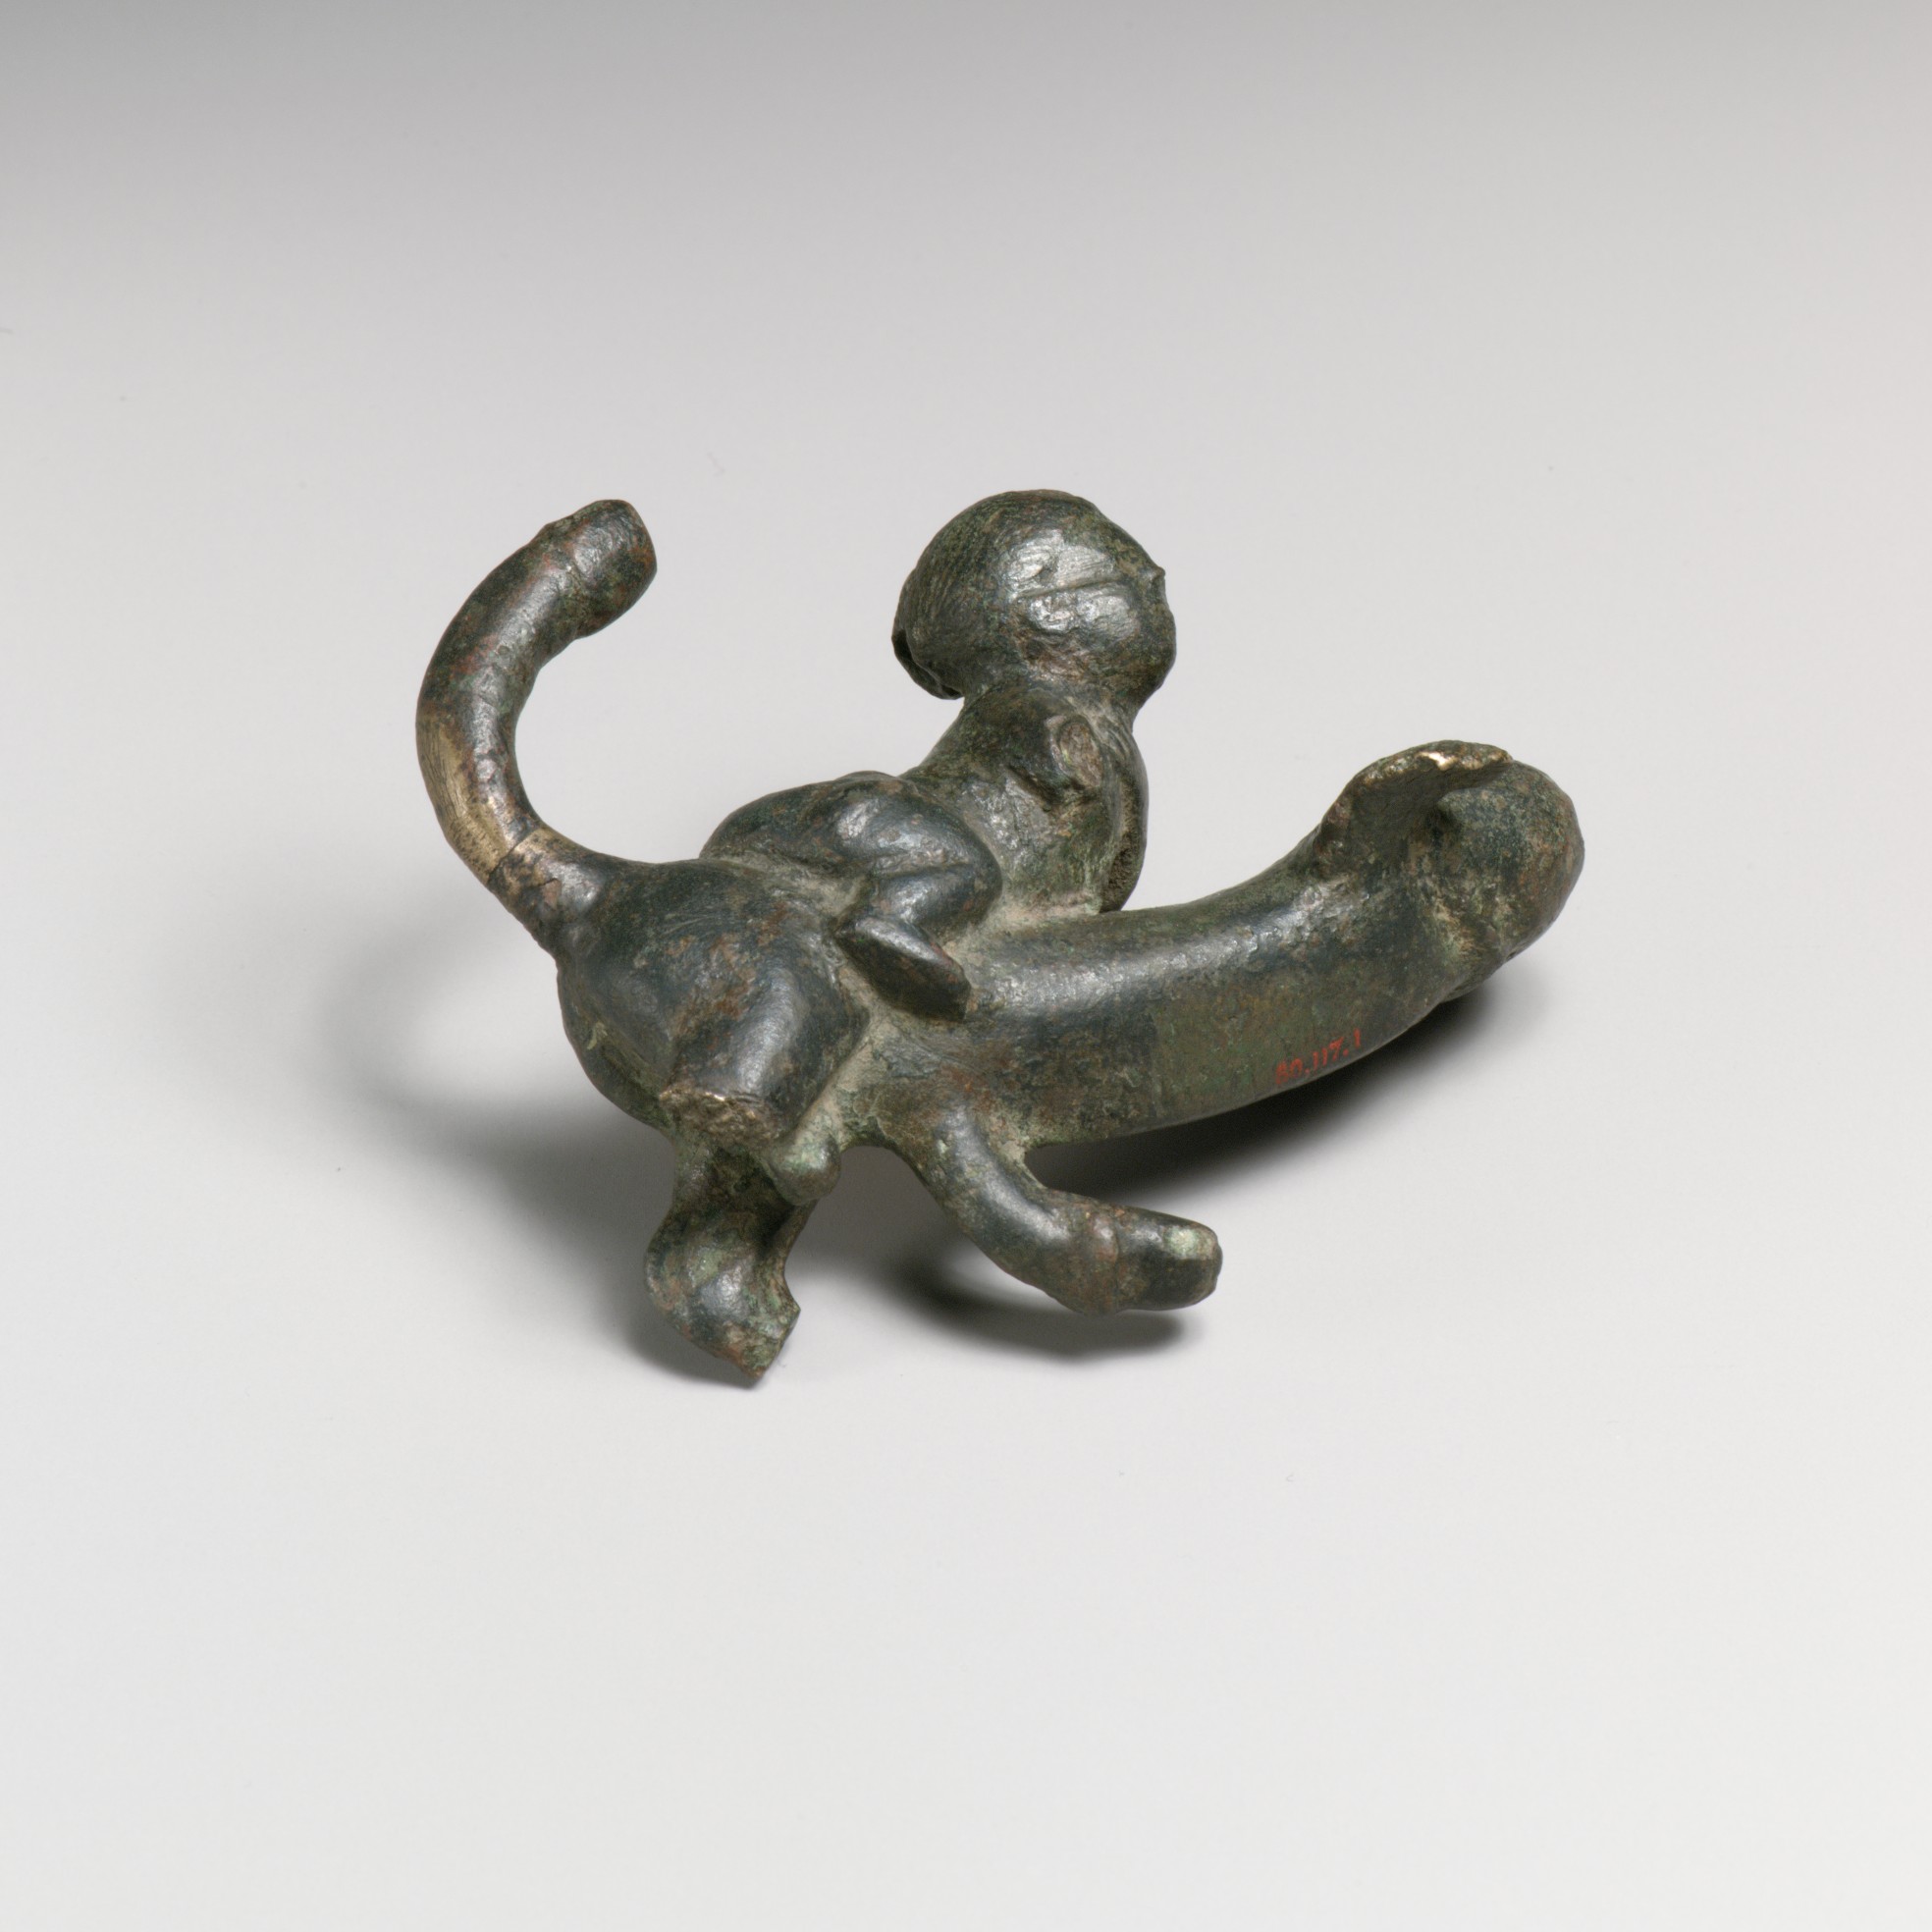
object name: amulet, grotesque ornament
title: Bronze phallic ornament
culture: roman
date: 1-100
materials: bronze